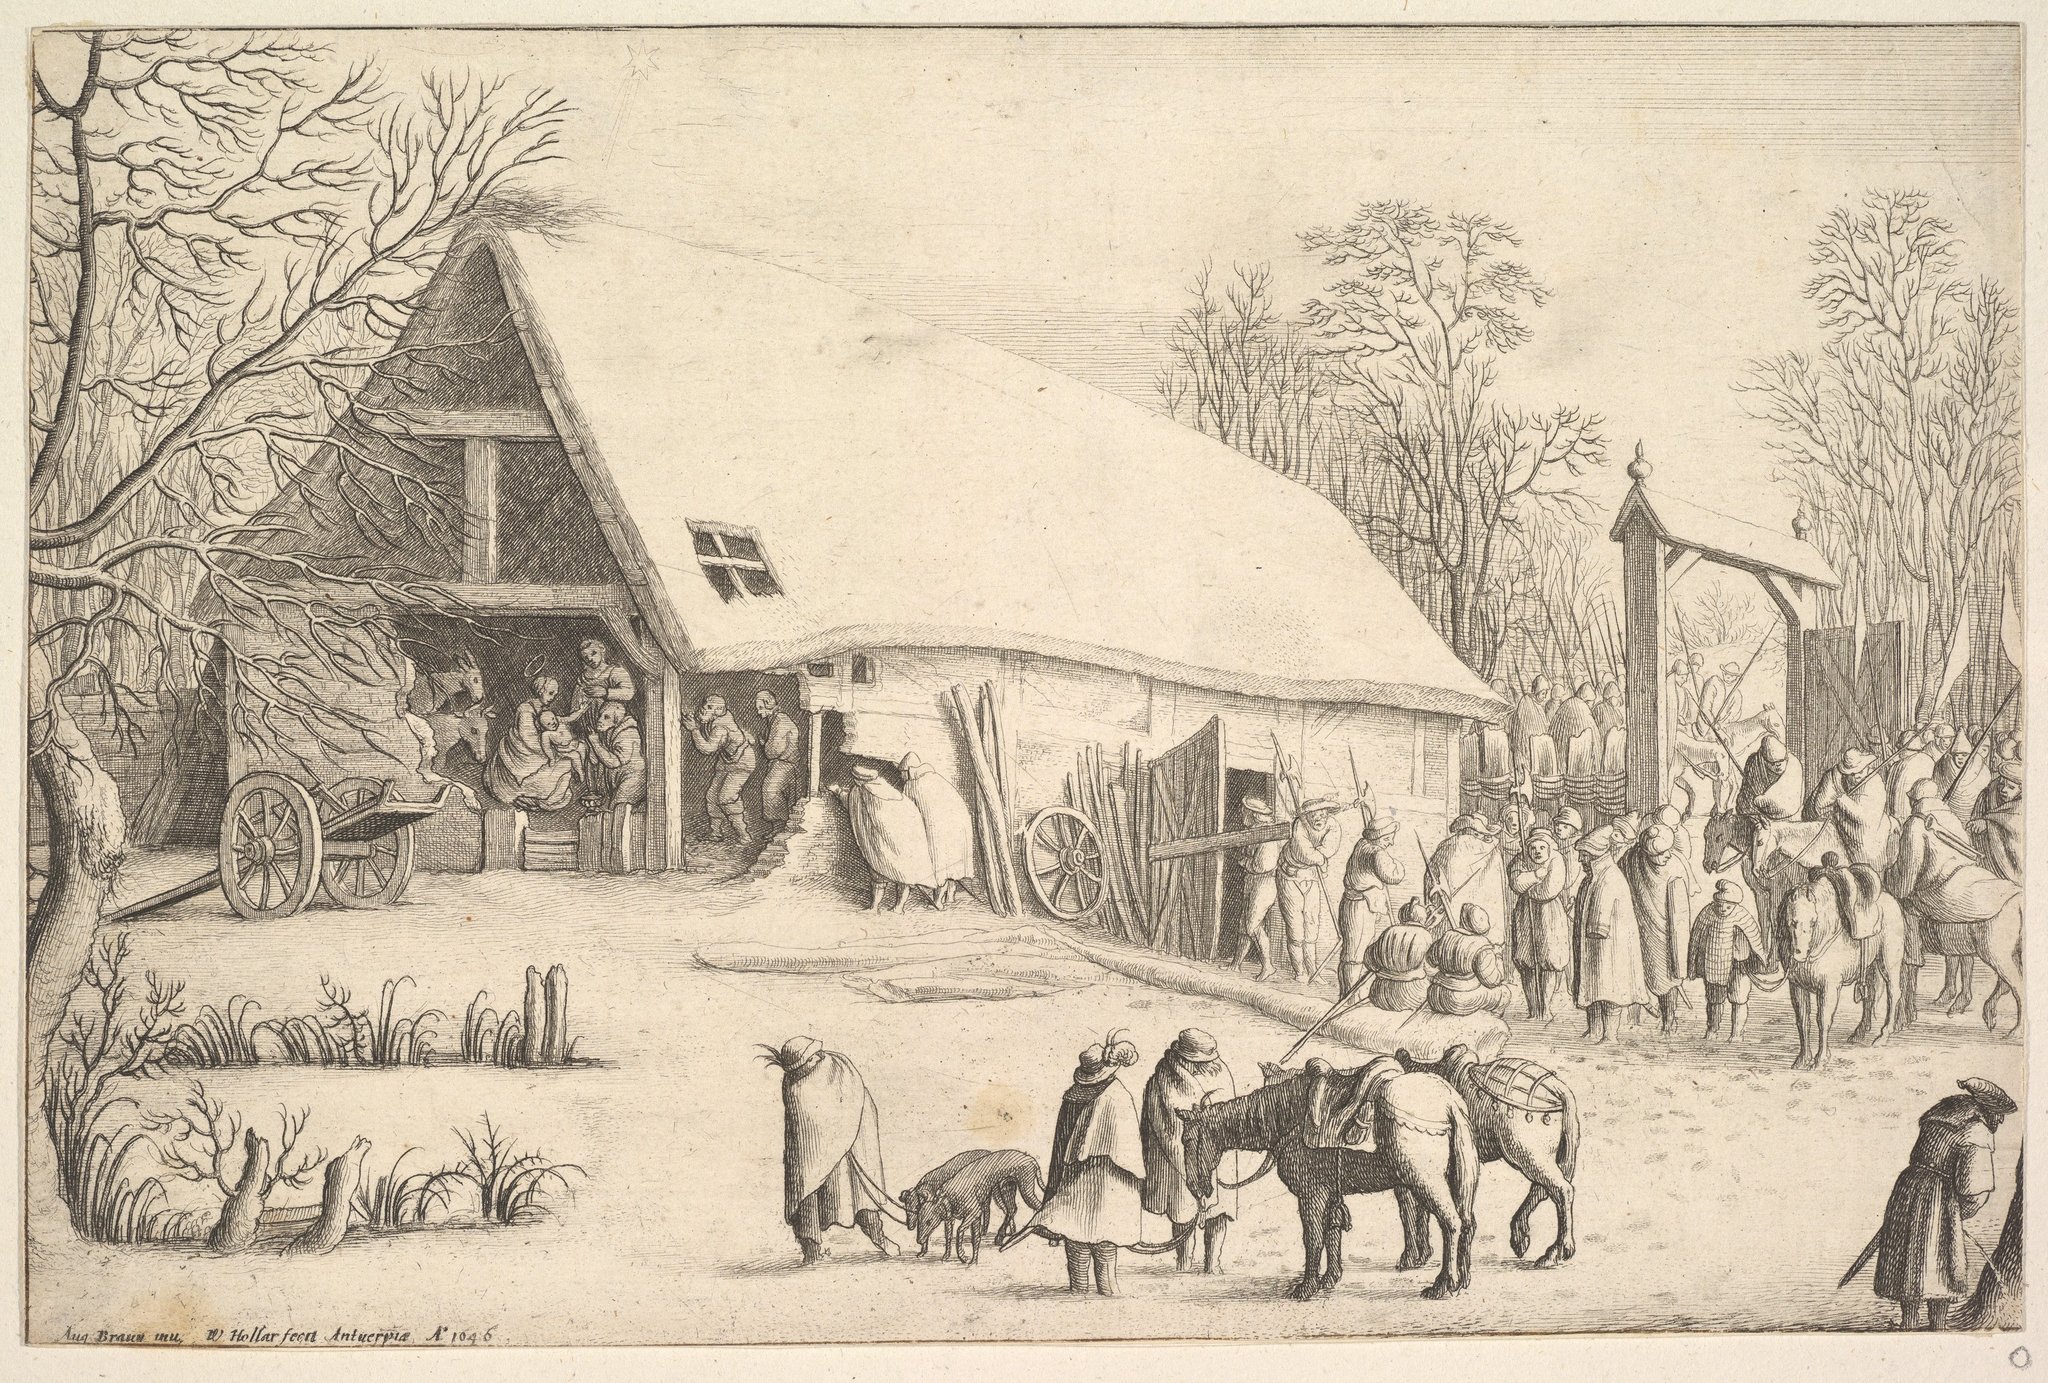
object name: print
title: Adoration of the Kings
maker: wenceslaus hollar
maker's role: artist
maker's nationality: bohemian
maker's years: 1607-1677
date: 1646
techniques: etching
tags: barns,dogs,horses,christ,virgin mary